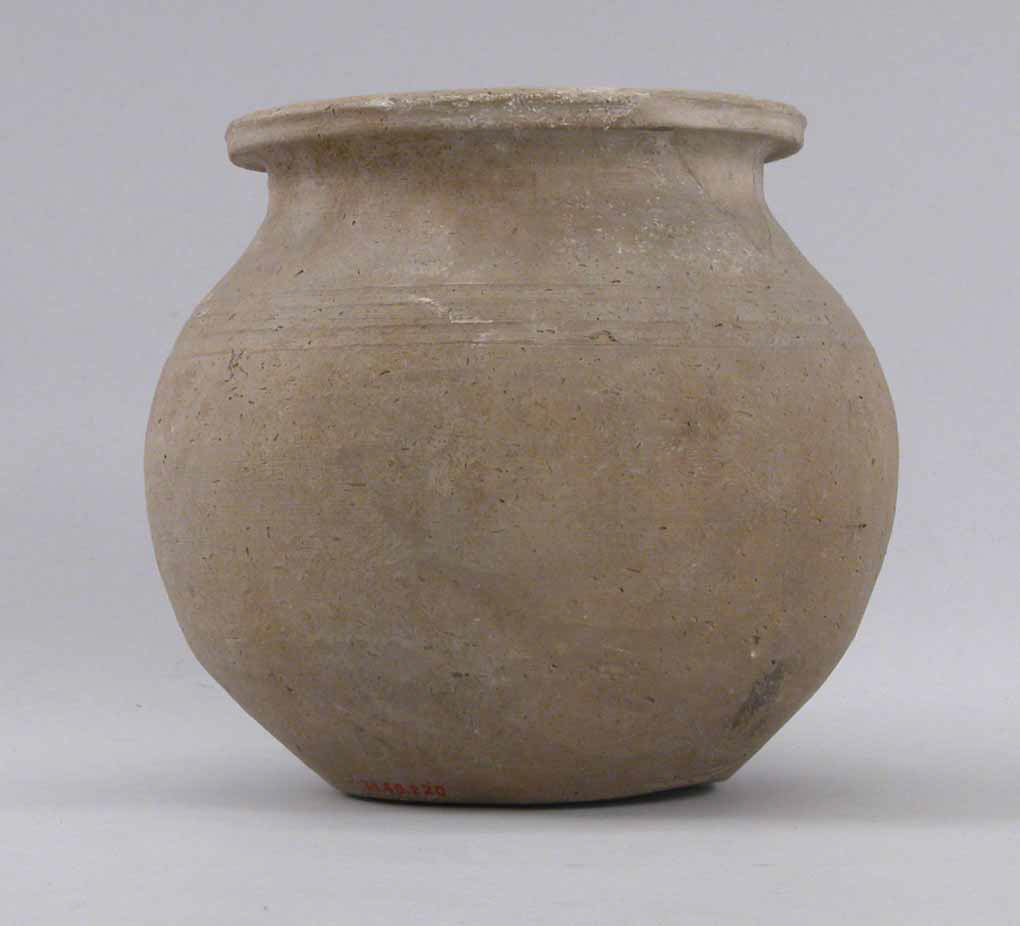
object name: jar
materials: earthenware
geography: iran